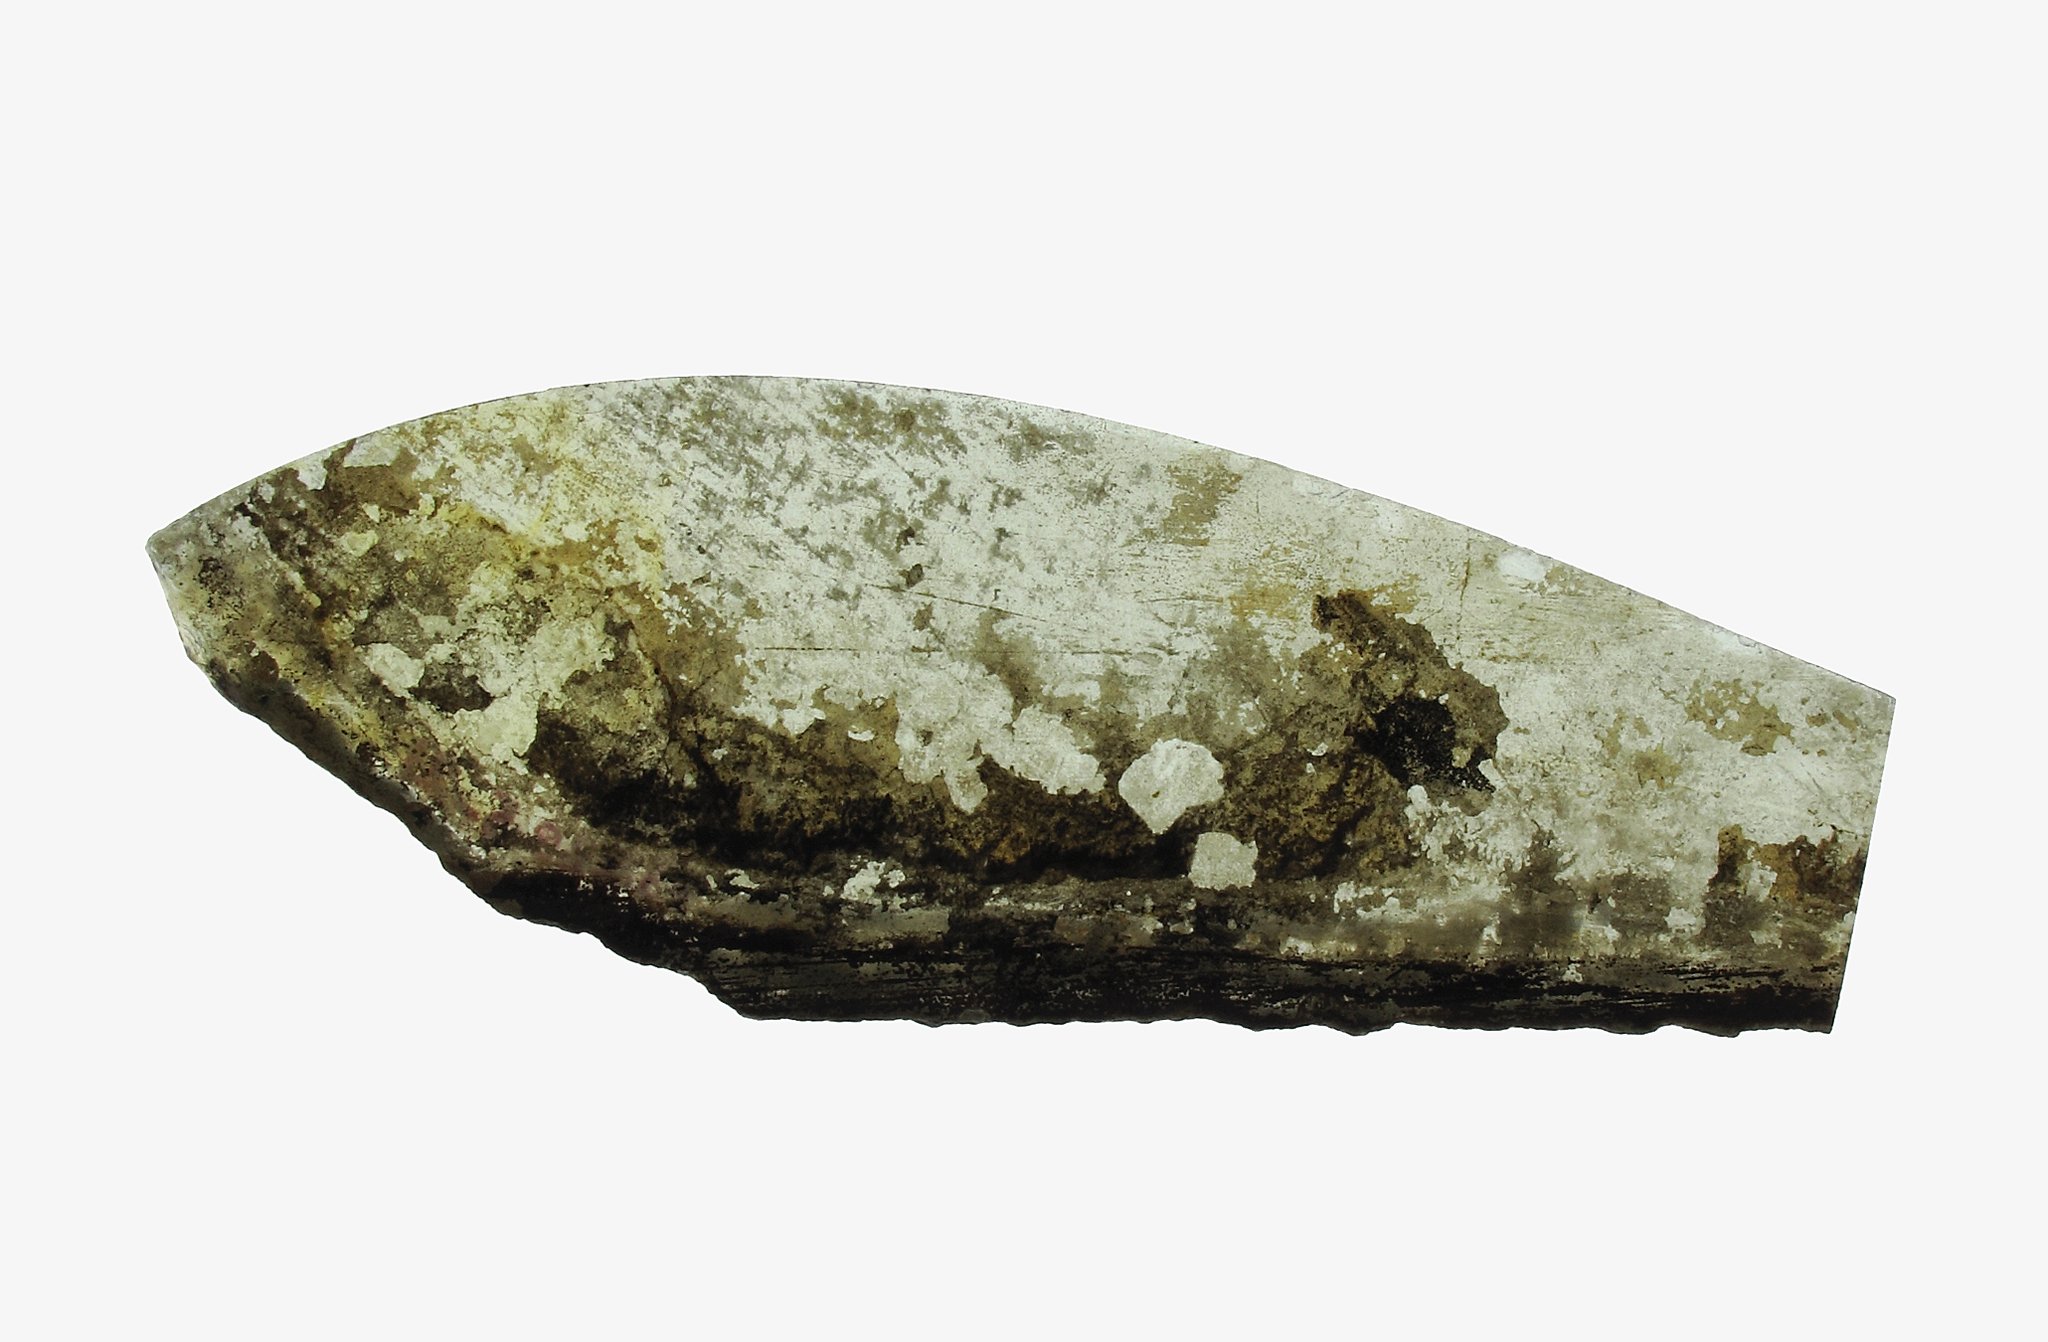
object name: fragment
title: Glass Fragment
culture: french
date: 1401-1500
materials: glass